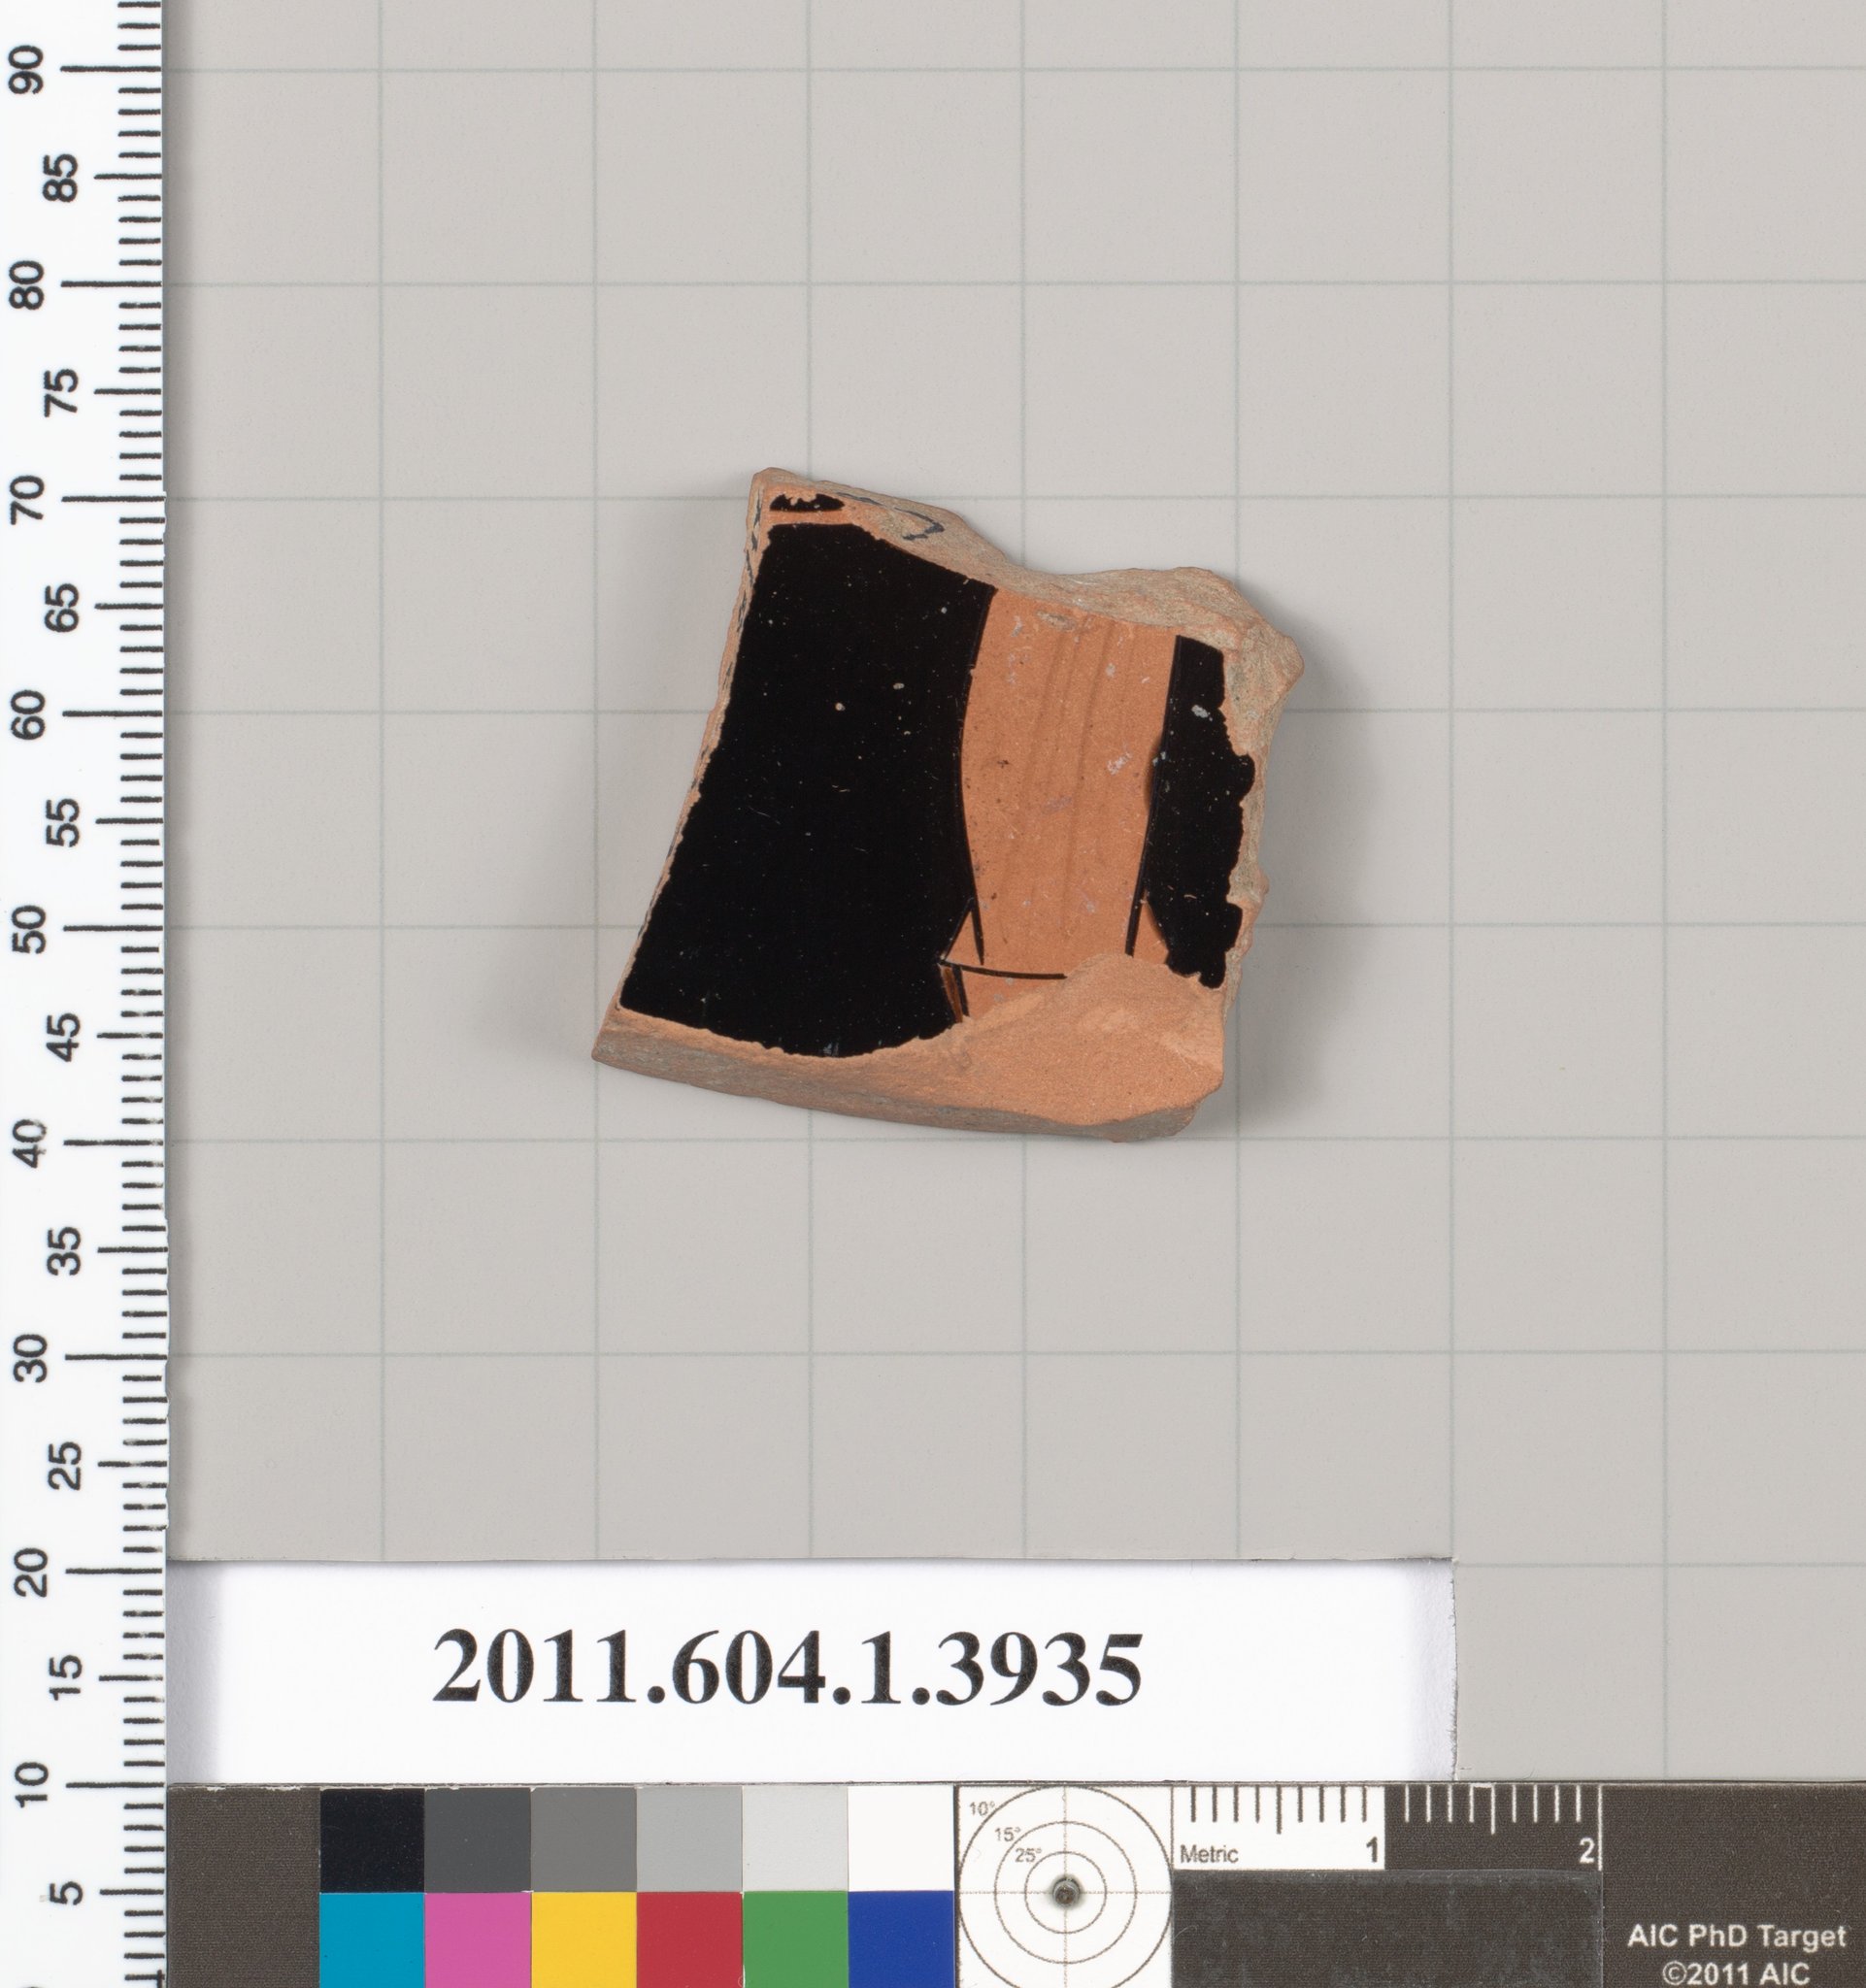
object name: kylix fragment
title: Terracotta fragment of a kylix (drinking cup)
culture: greek, attic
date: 500-480 BCE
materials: terracotta